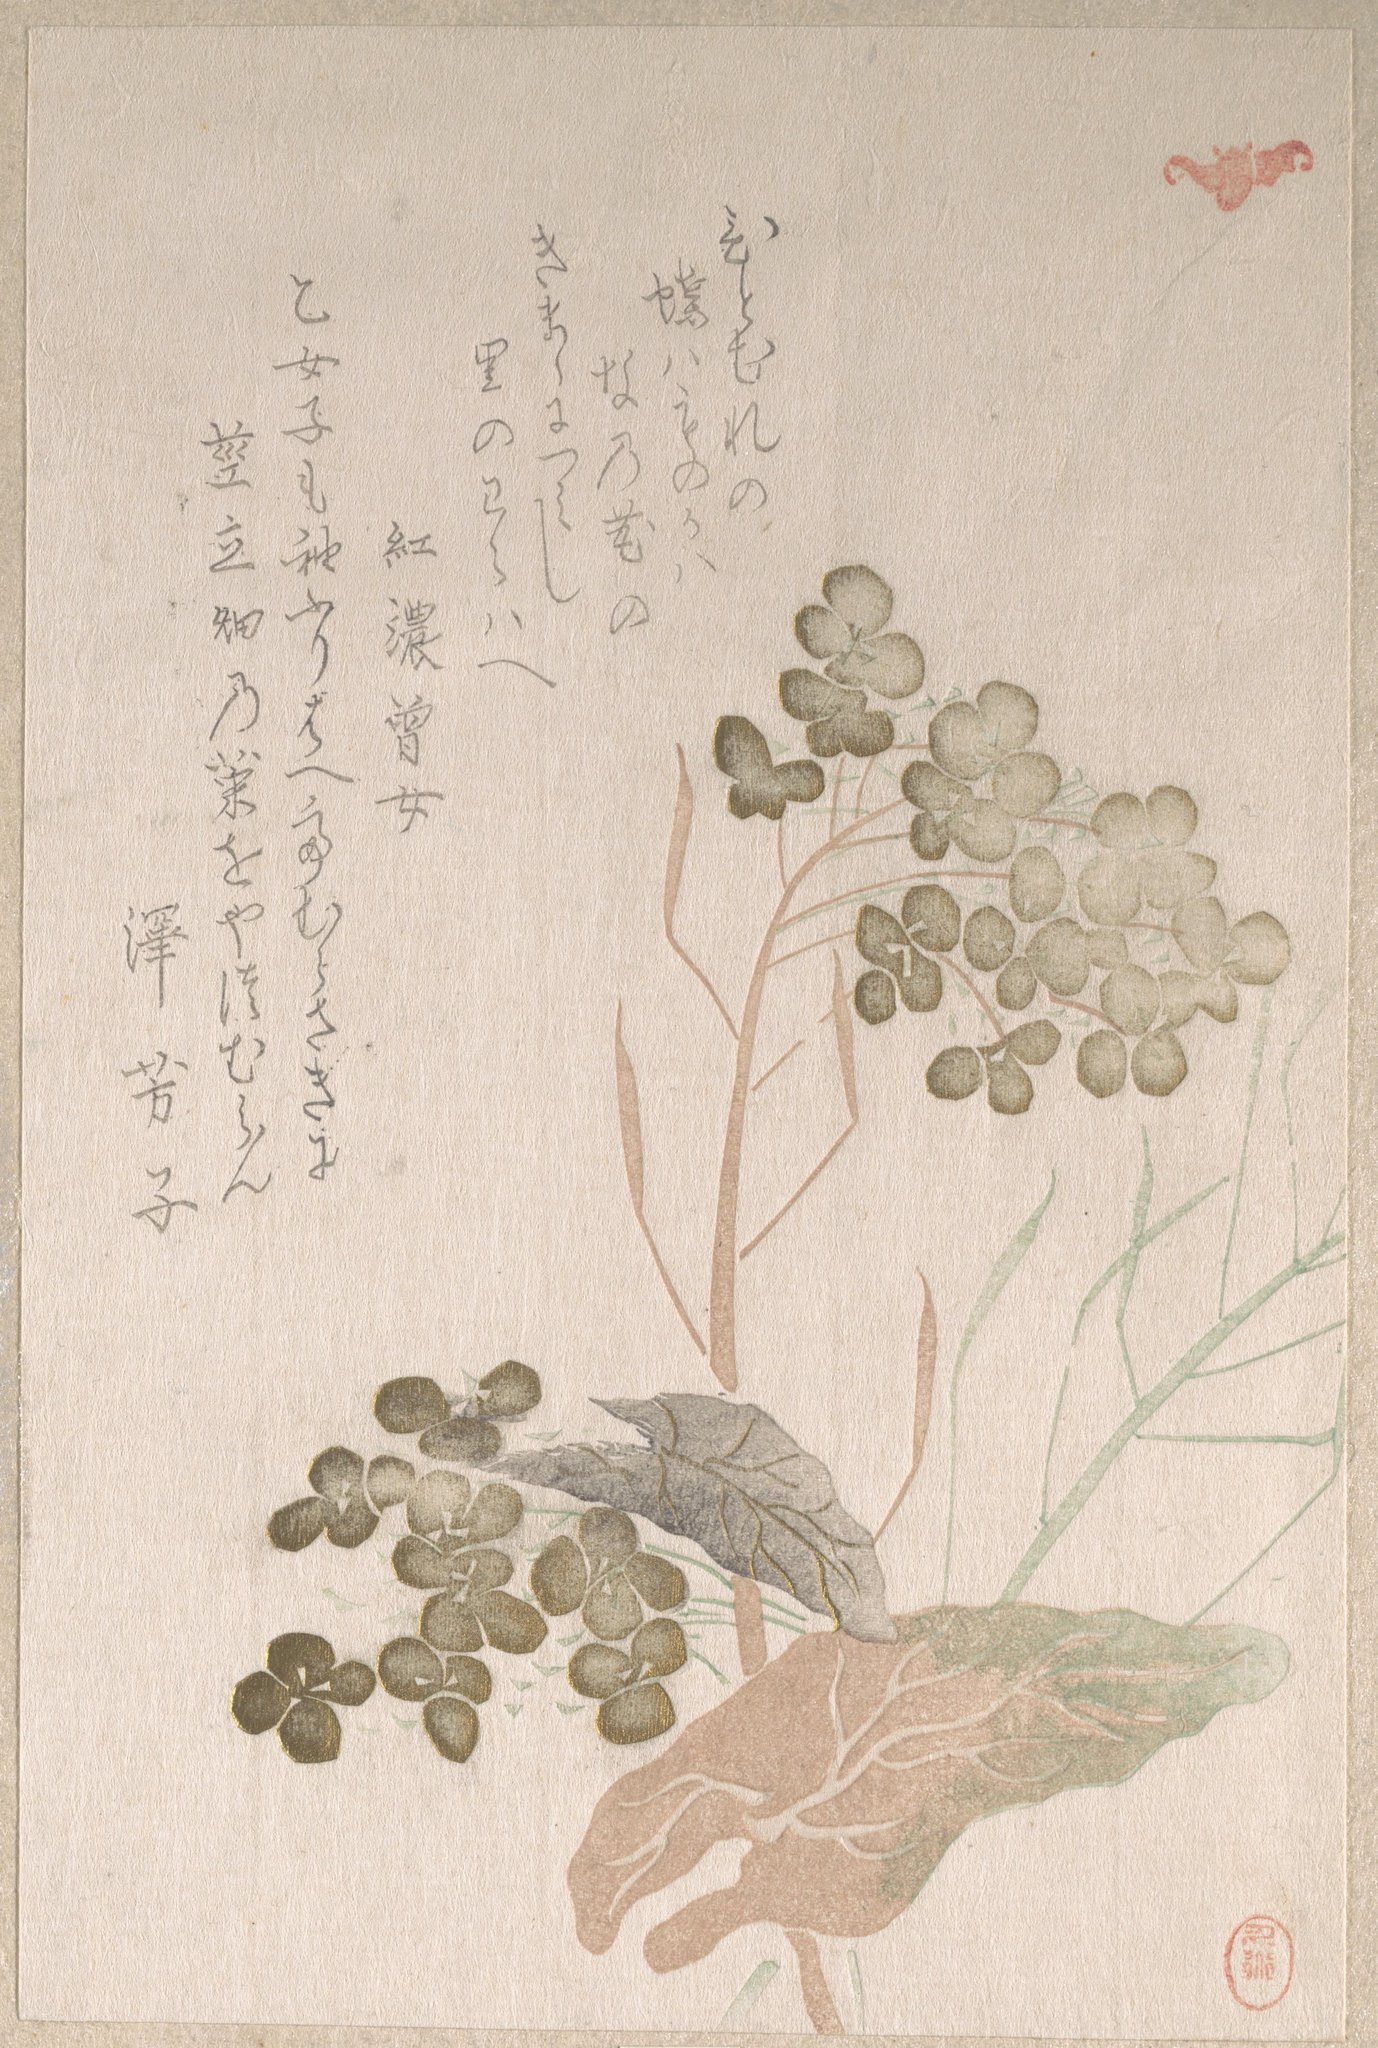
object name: print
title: Natane Flower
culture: japanese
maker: unidentified artist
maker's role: artist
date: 1801-1900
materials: ink, paper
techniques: surimono, woodblock print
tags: flowers,leaves